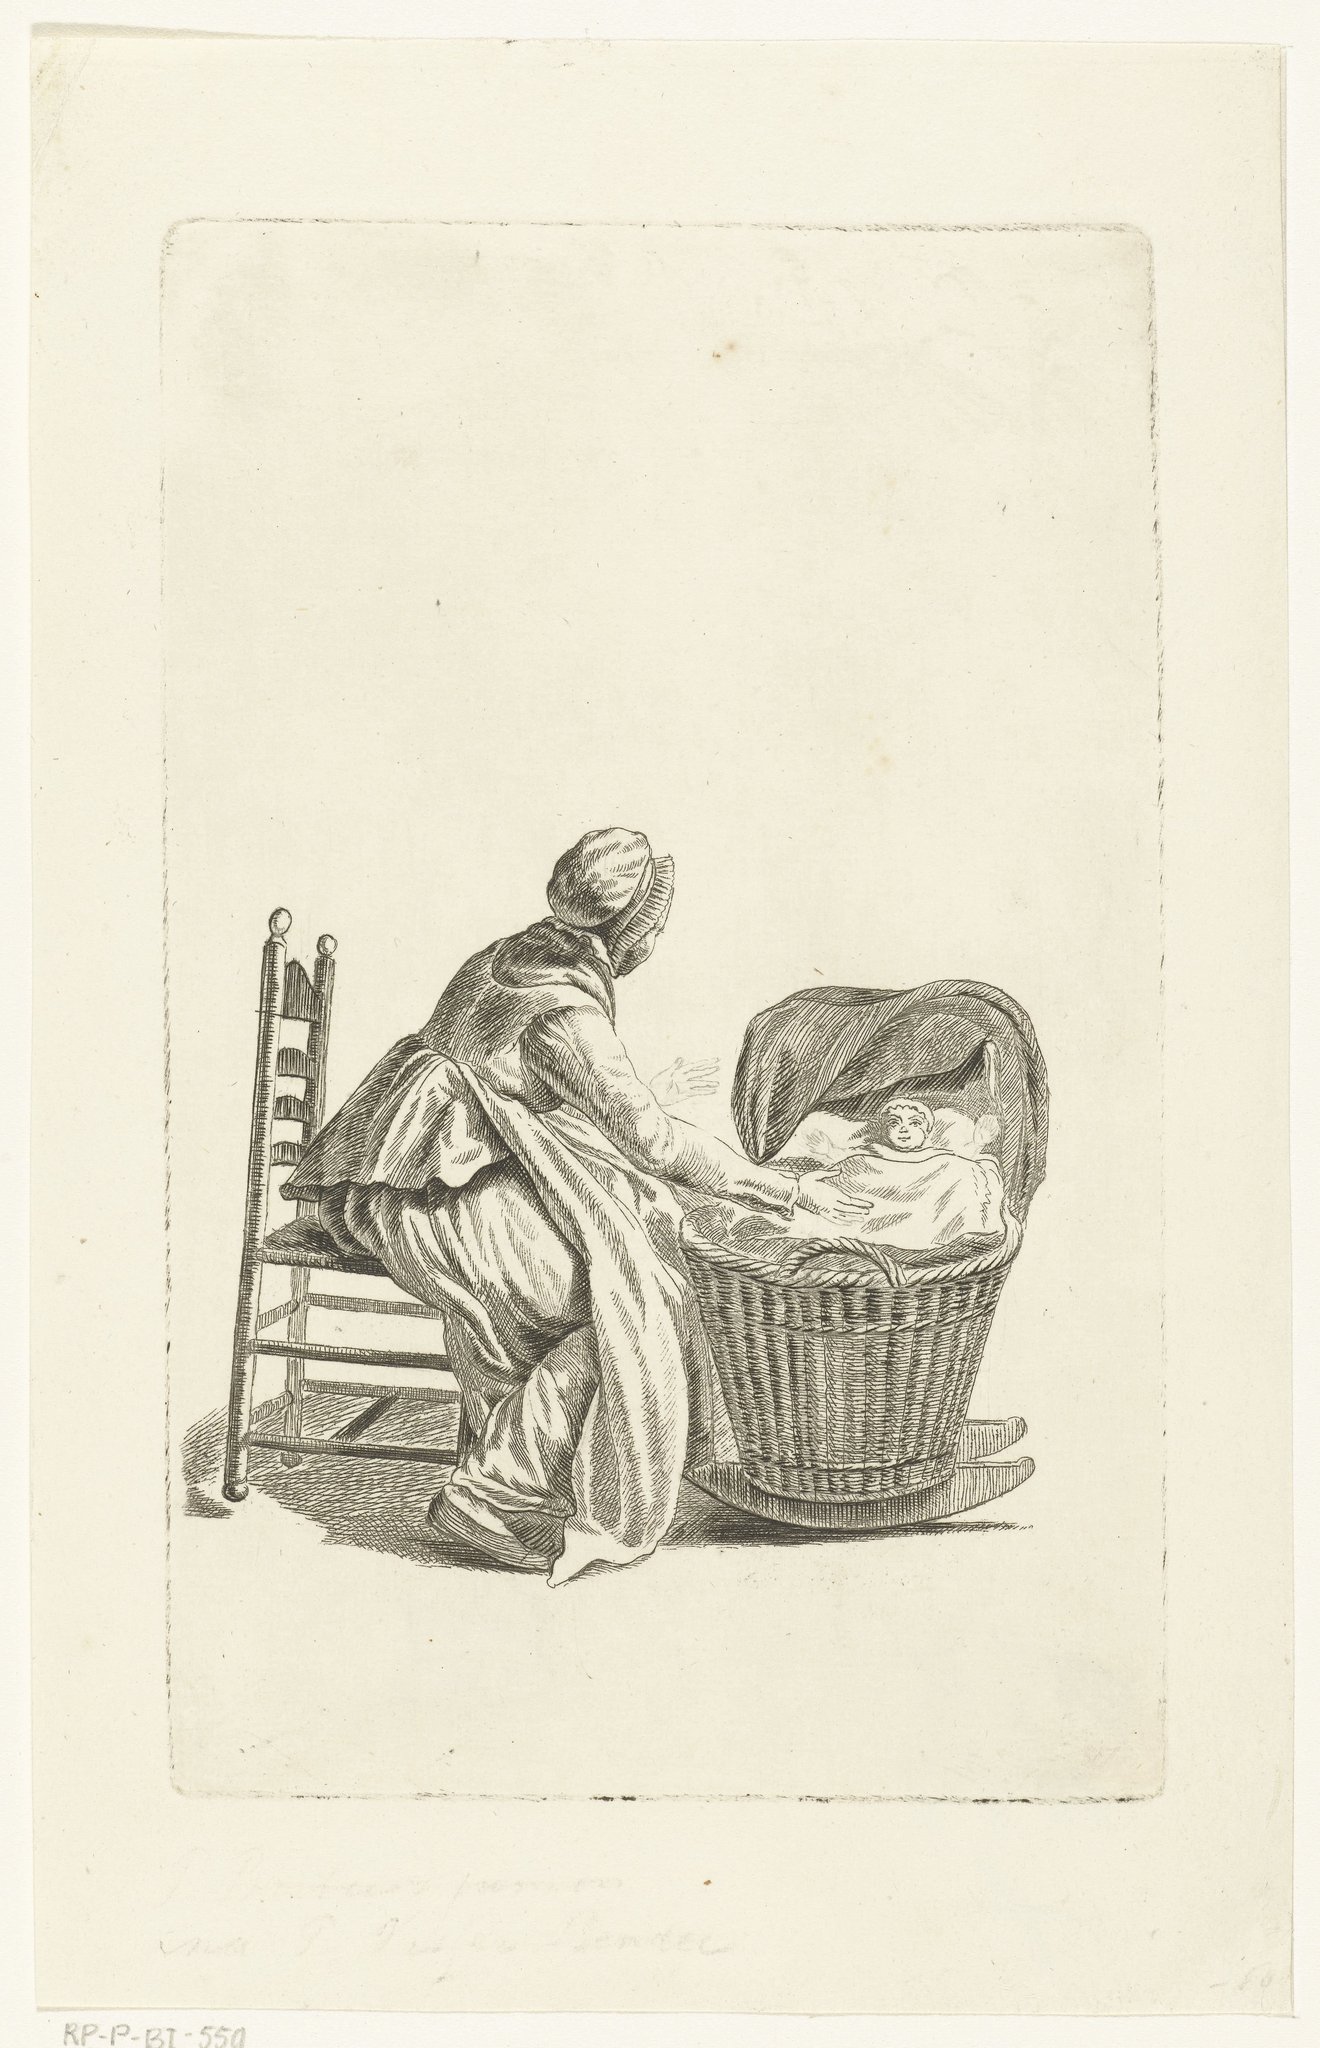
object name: print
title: Vrouw op stoel buigt zich naar kind in wieg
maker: pieter barbiers (iv)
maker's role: painter, print maker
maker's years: 1798-1848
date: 1808-1848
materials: paper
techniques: etching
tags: cradle, crib, mother and baby or young child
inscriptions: collector's mark: Lugt 2228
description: Prent naar ontwerp van P. Visser Bender.